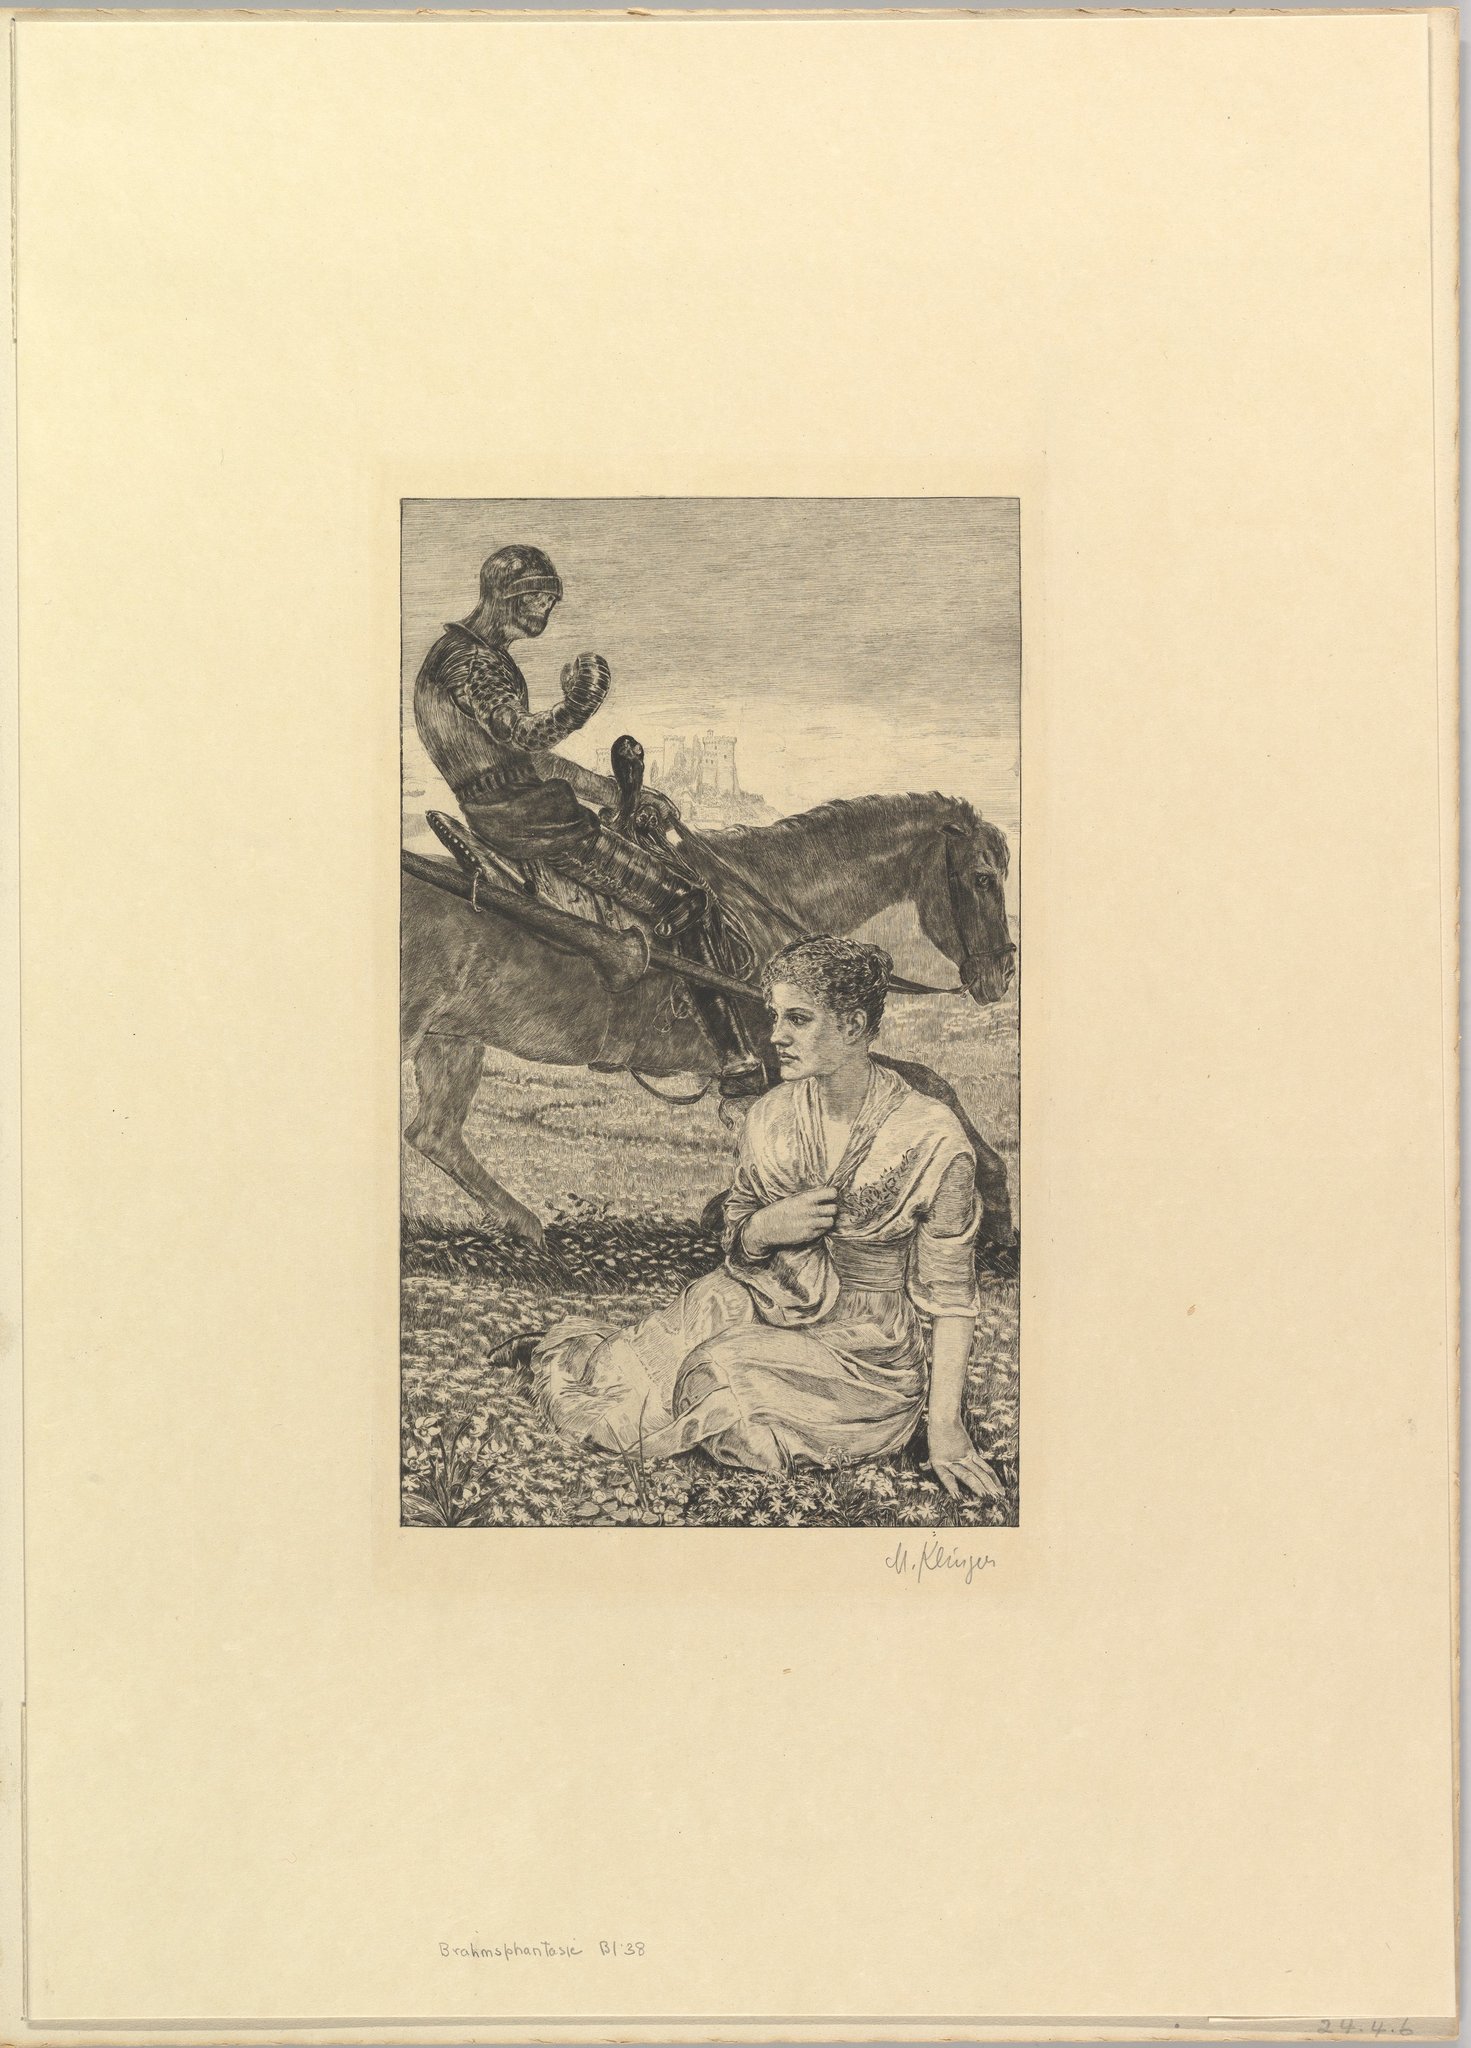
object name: print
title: Ritter Tod, from the series Brahmsphantasie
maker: max klinger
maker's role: artist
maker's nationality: german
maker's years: 1857-1920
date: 1894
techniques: aquatint, engraving, etching, mezzotint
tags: soldiers,women,horses,flowers